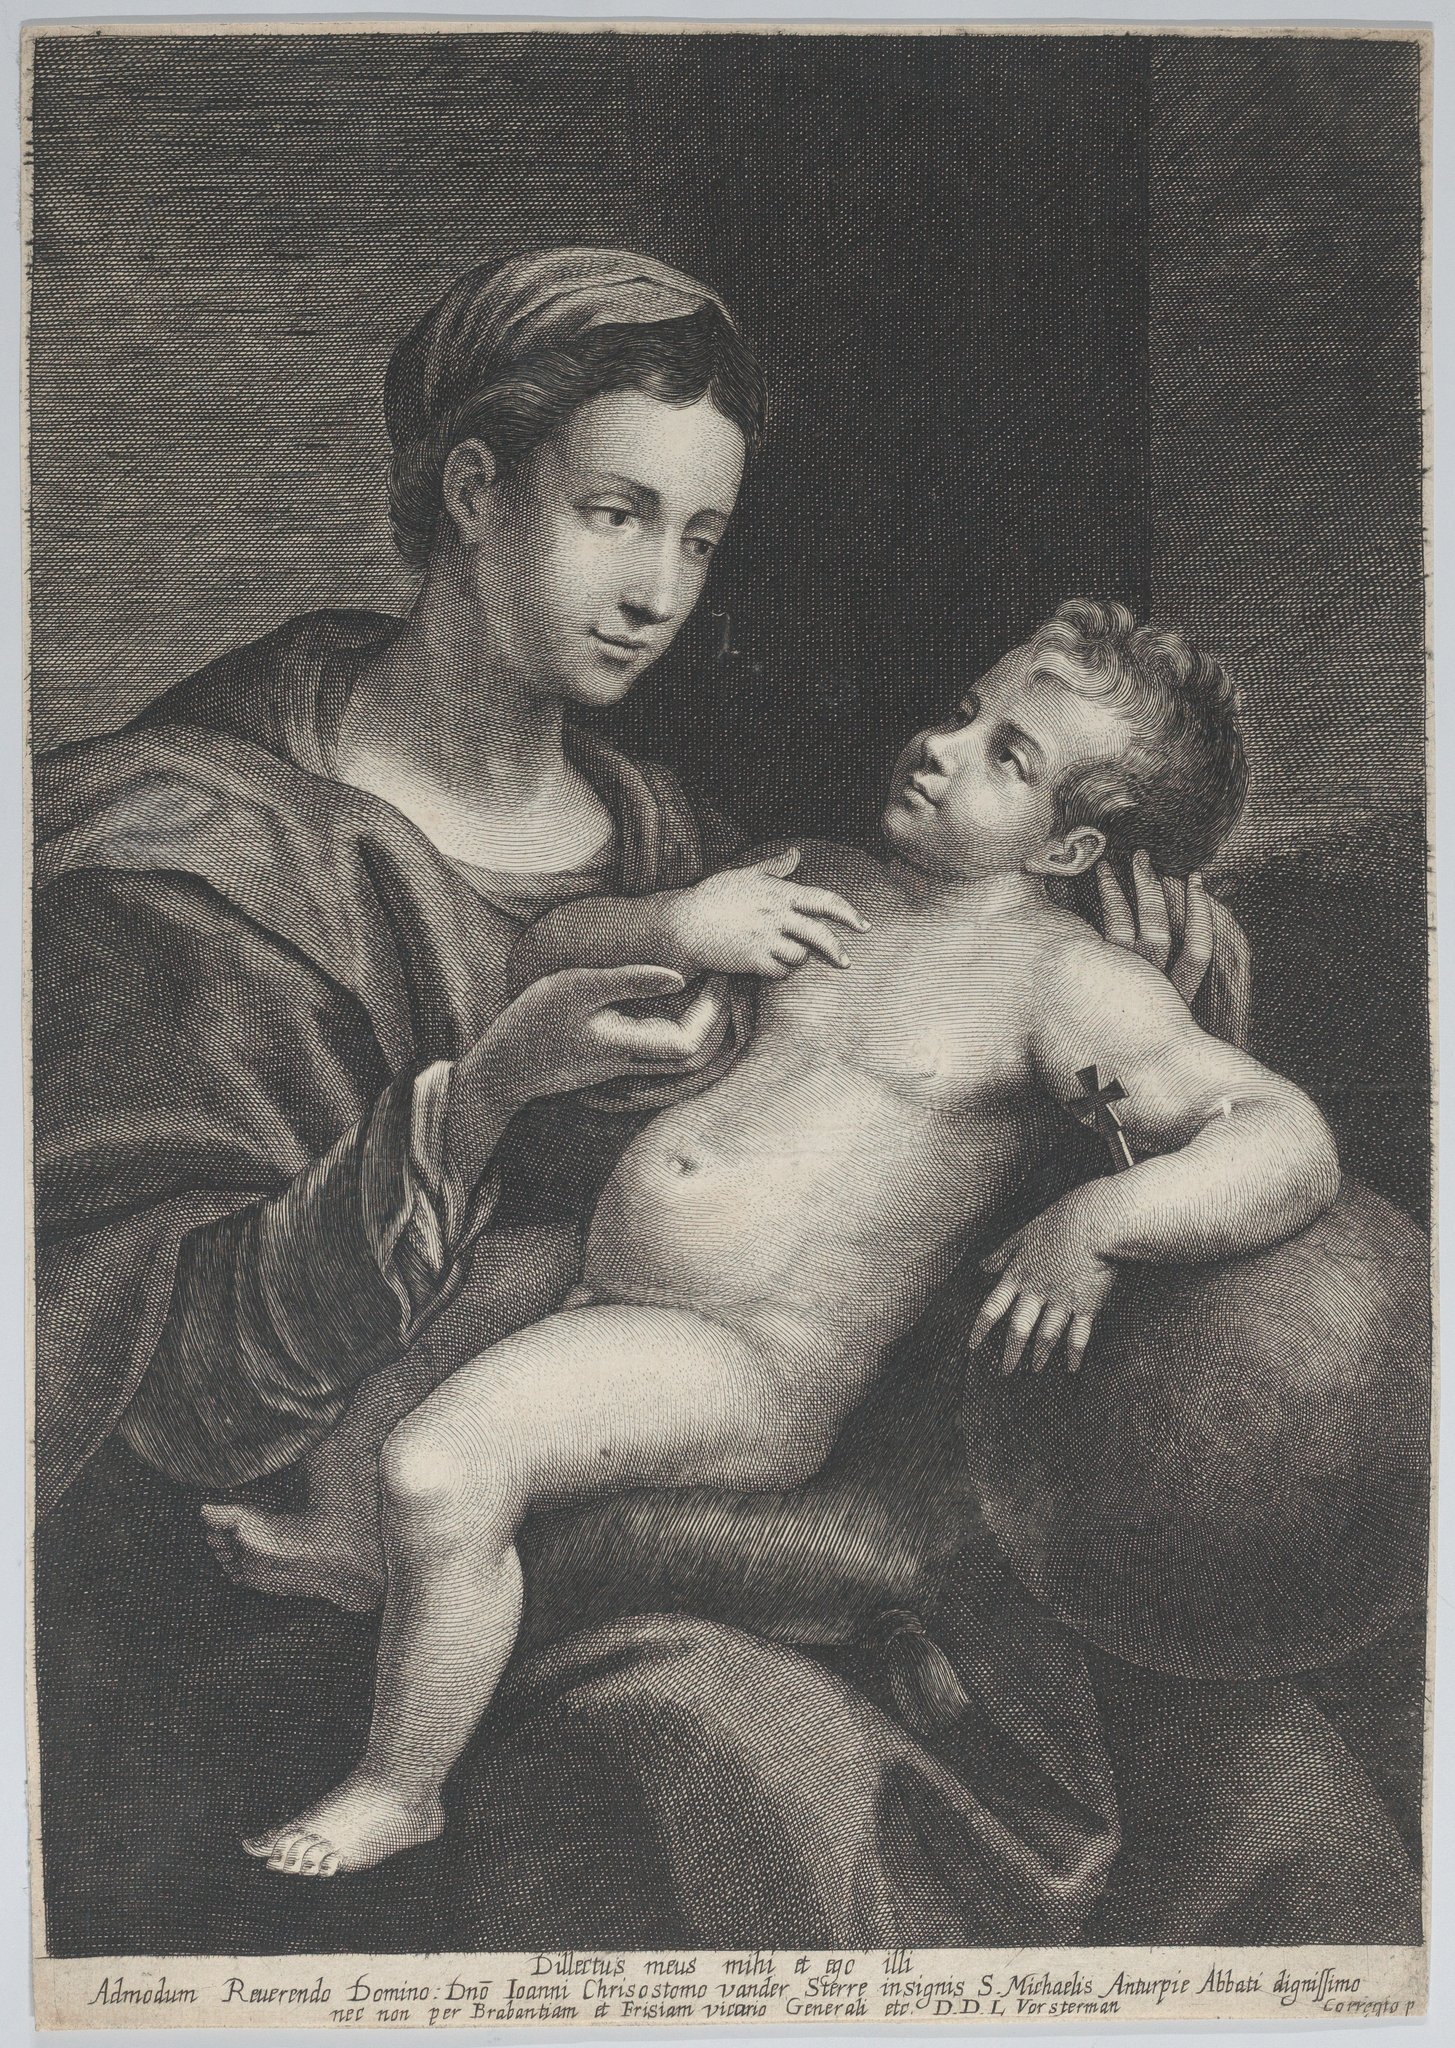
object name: print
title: Virgin and Child, with the Christ child leaning against an orb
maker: lucas vorsterman (i)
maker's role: artist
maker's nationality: flemish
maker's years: 1595-1675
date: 1628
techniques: engraving